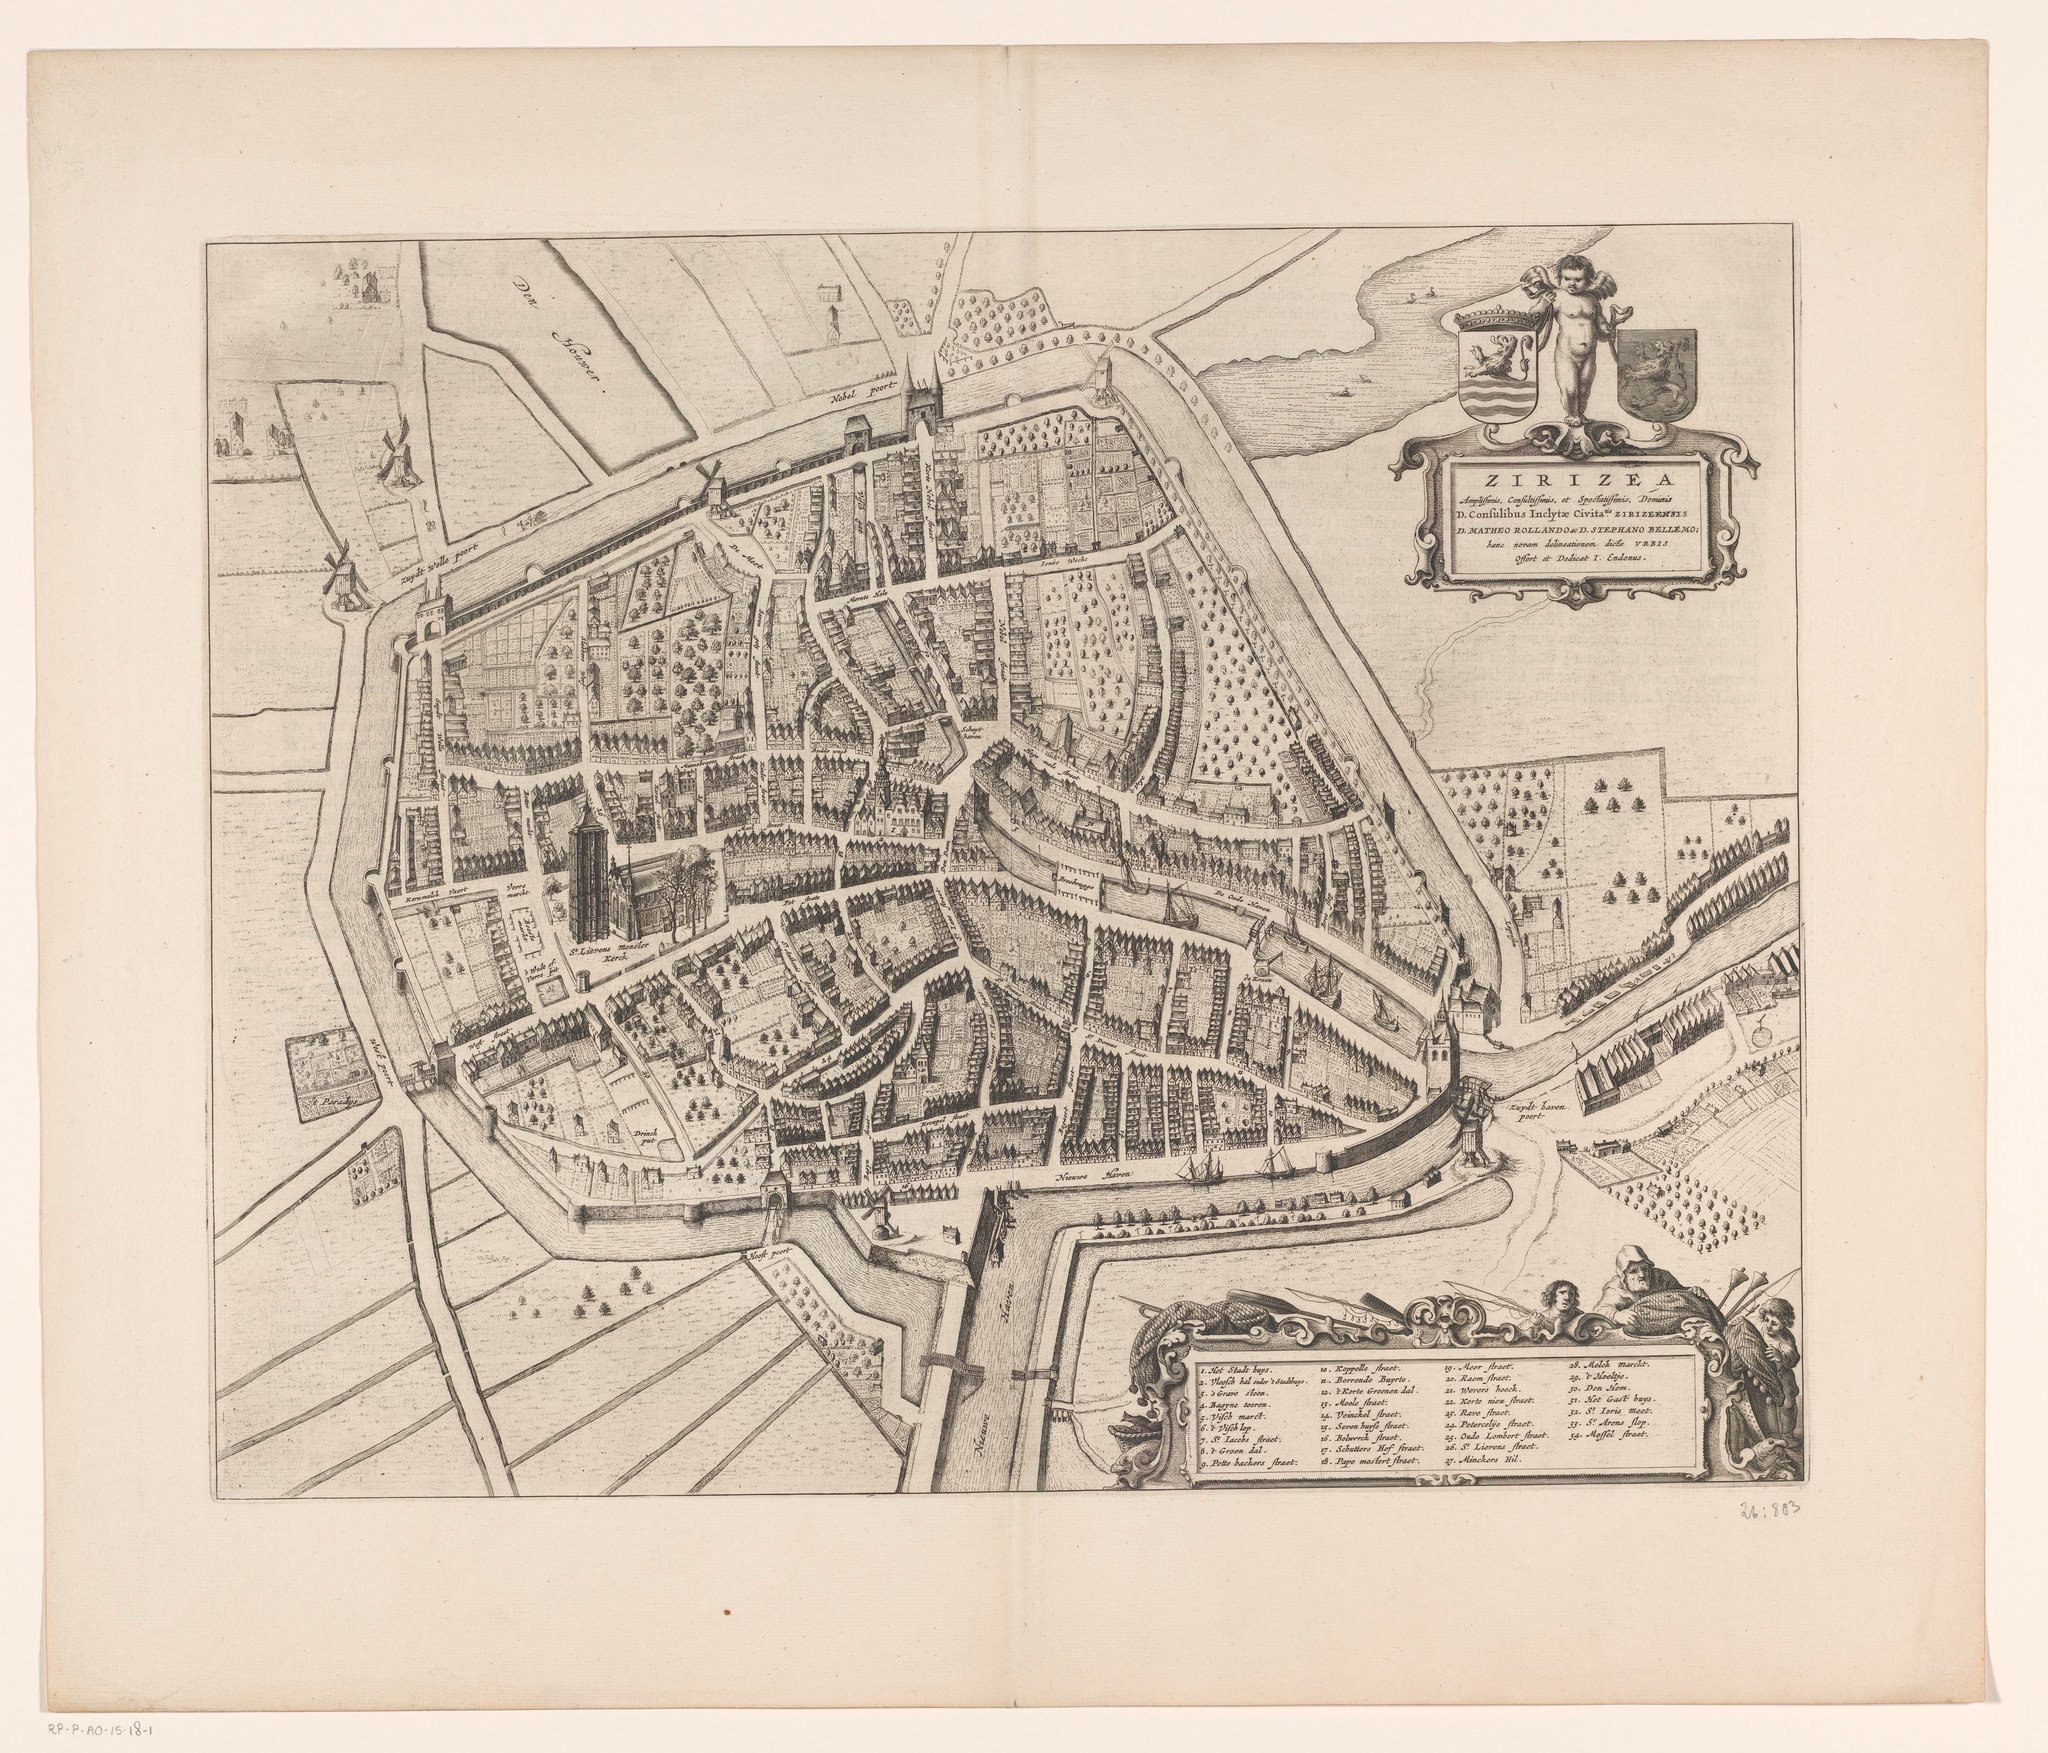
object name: print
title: Zirizea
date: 1652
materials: paper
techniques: engraving, etching, letterpress printing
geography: amsterdam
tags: coat of arms (as symbol of the state, etc.) (+ city; municipal), maps of cities, coat of arms (as symbol of the state, etc.) (+ province; provincial)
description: Plattegrond in vogelvluchtperspectief. Rechtsboven de titelcartouche met het wapen van Zeeland en dat van Zierikzee. Rechtsonder een cartouche met de legenda 1-34. Op verso Latijnse tekst.